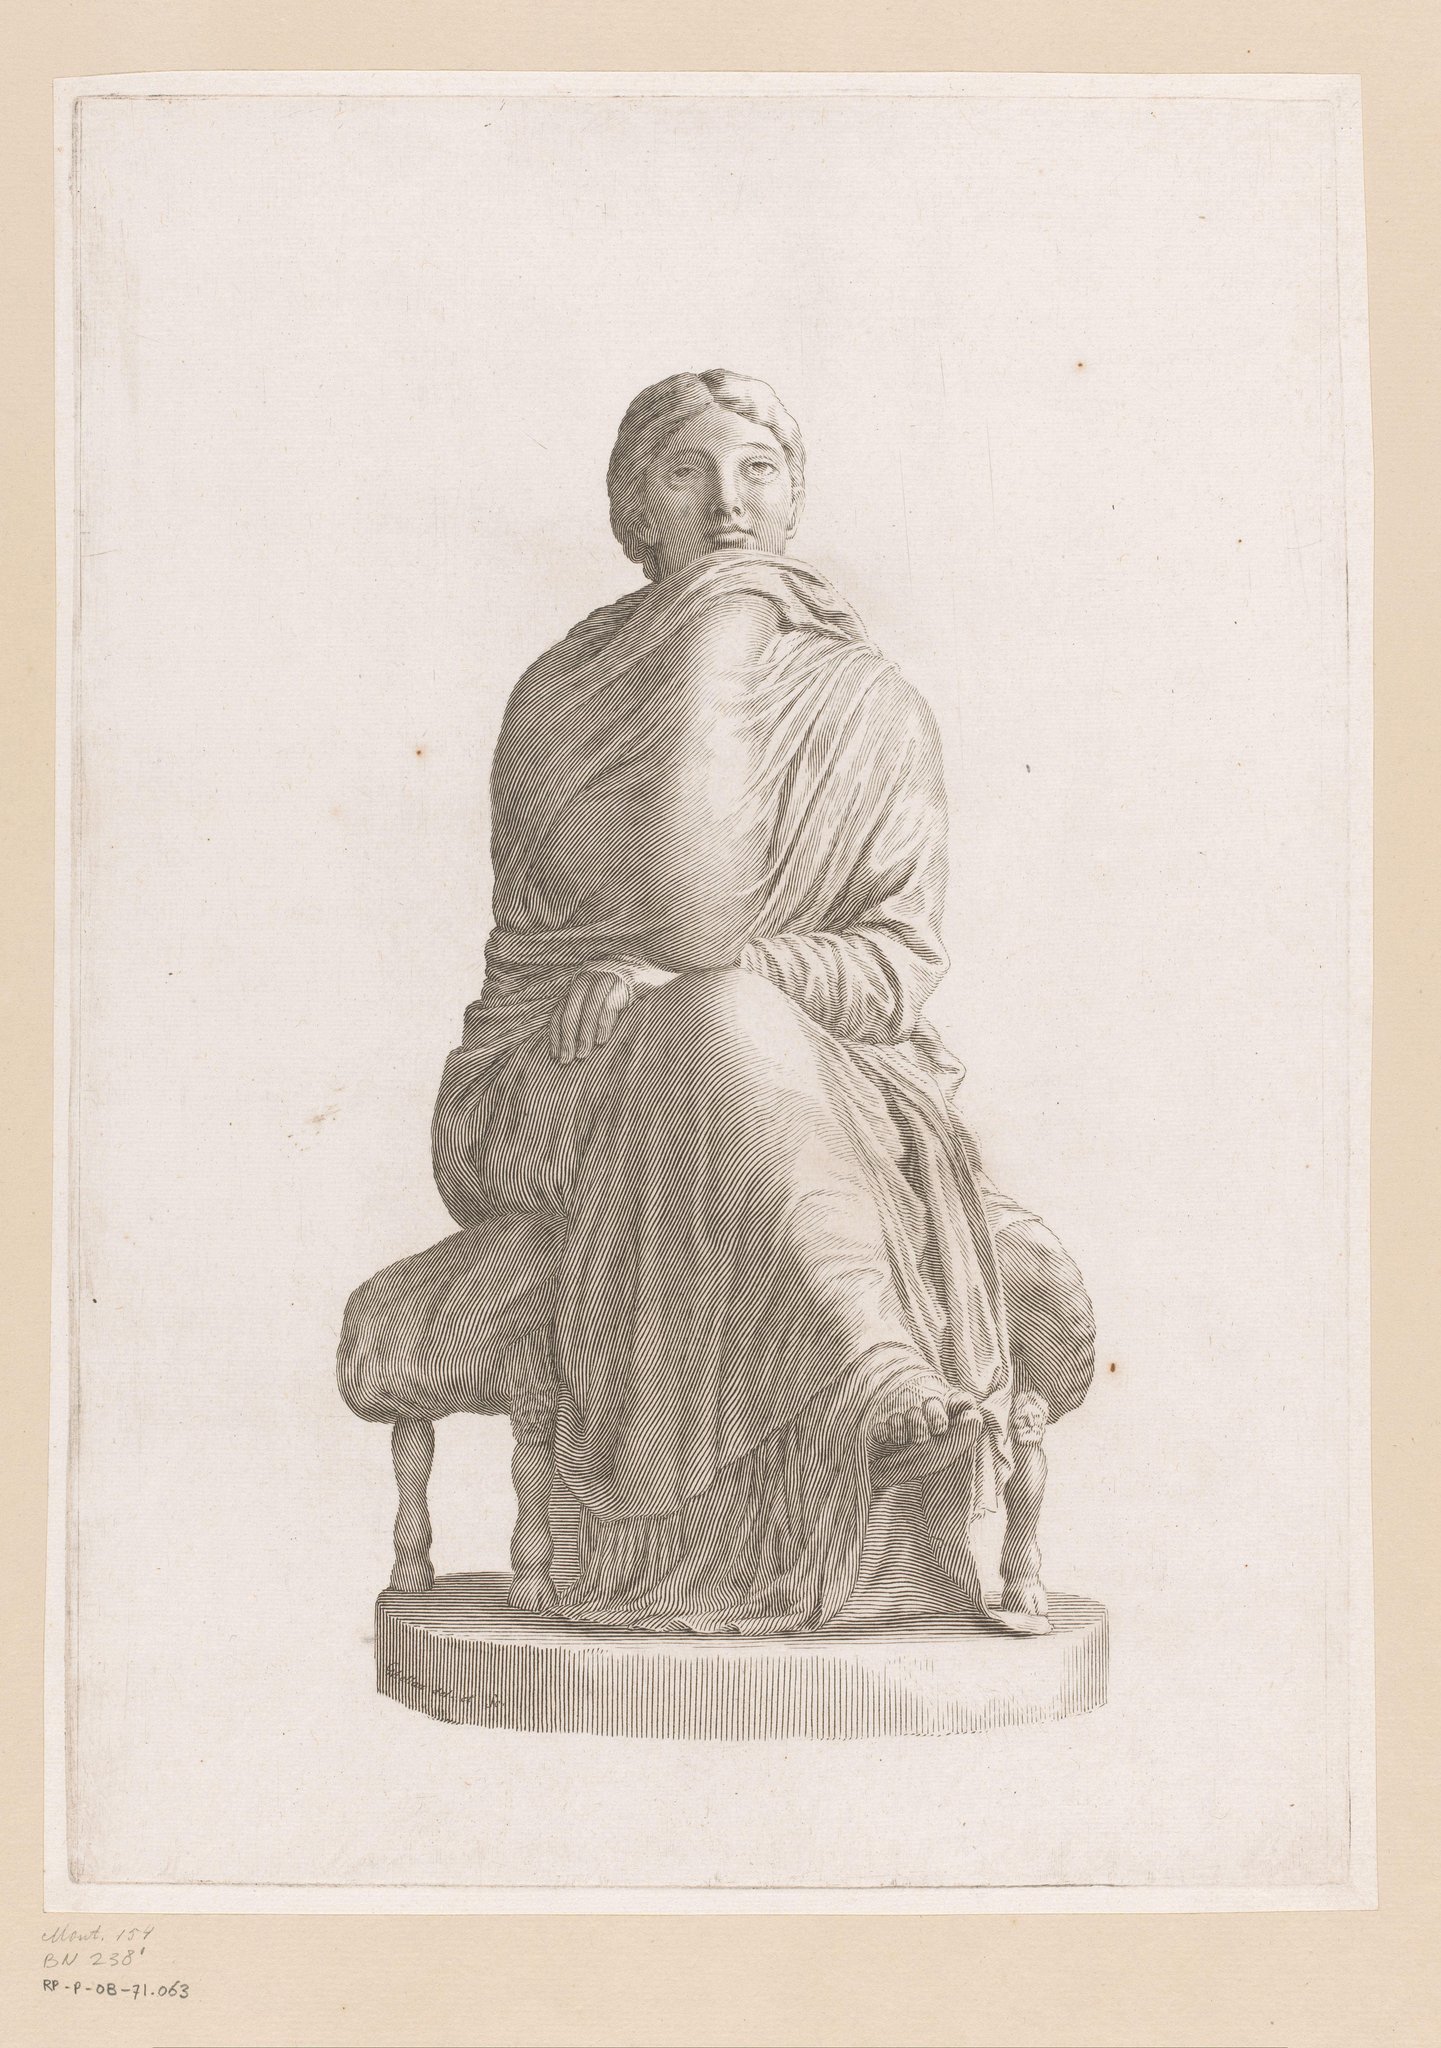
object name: print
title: Standbeeld van een zittende vrouw in draperie gewikkeld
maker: claude mellan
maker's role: draughtsman, print maker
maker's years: 1598-1688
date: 1608-1677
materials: paper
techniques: engraving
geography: france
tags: sitting figure - aa - female human figure, piece of sculpture, reproduction of a piece of sculpture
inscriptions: collector's mark: Lugt 240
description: Prent gebruikt voor: Félibien, André. Tableaux du Cabinet du roy. Statues et bustes antiques des maisons royales. Parijs: Imprimerie Royale, 1677. Het boek bevat 61 prenten van beelden en bustes uit Franse koninklijke collectie. Mellan vervaardigde in totaal achttien platen (zie ook British Museum, inv.nr. 1874,0808.1488). Het beeld, ook bekend als 'Mnémosyne', bevindt zich op het terras van het palais Compiègne.